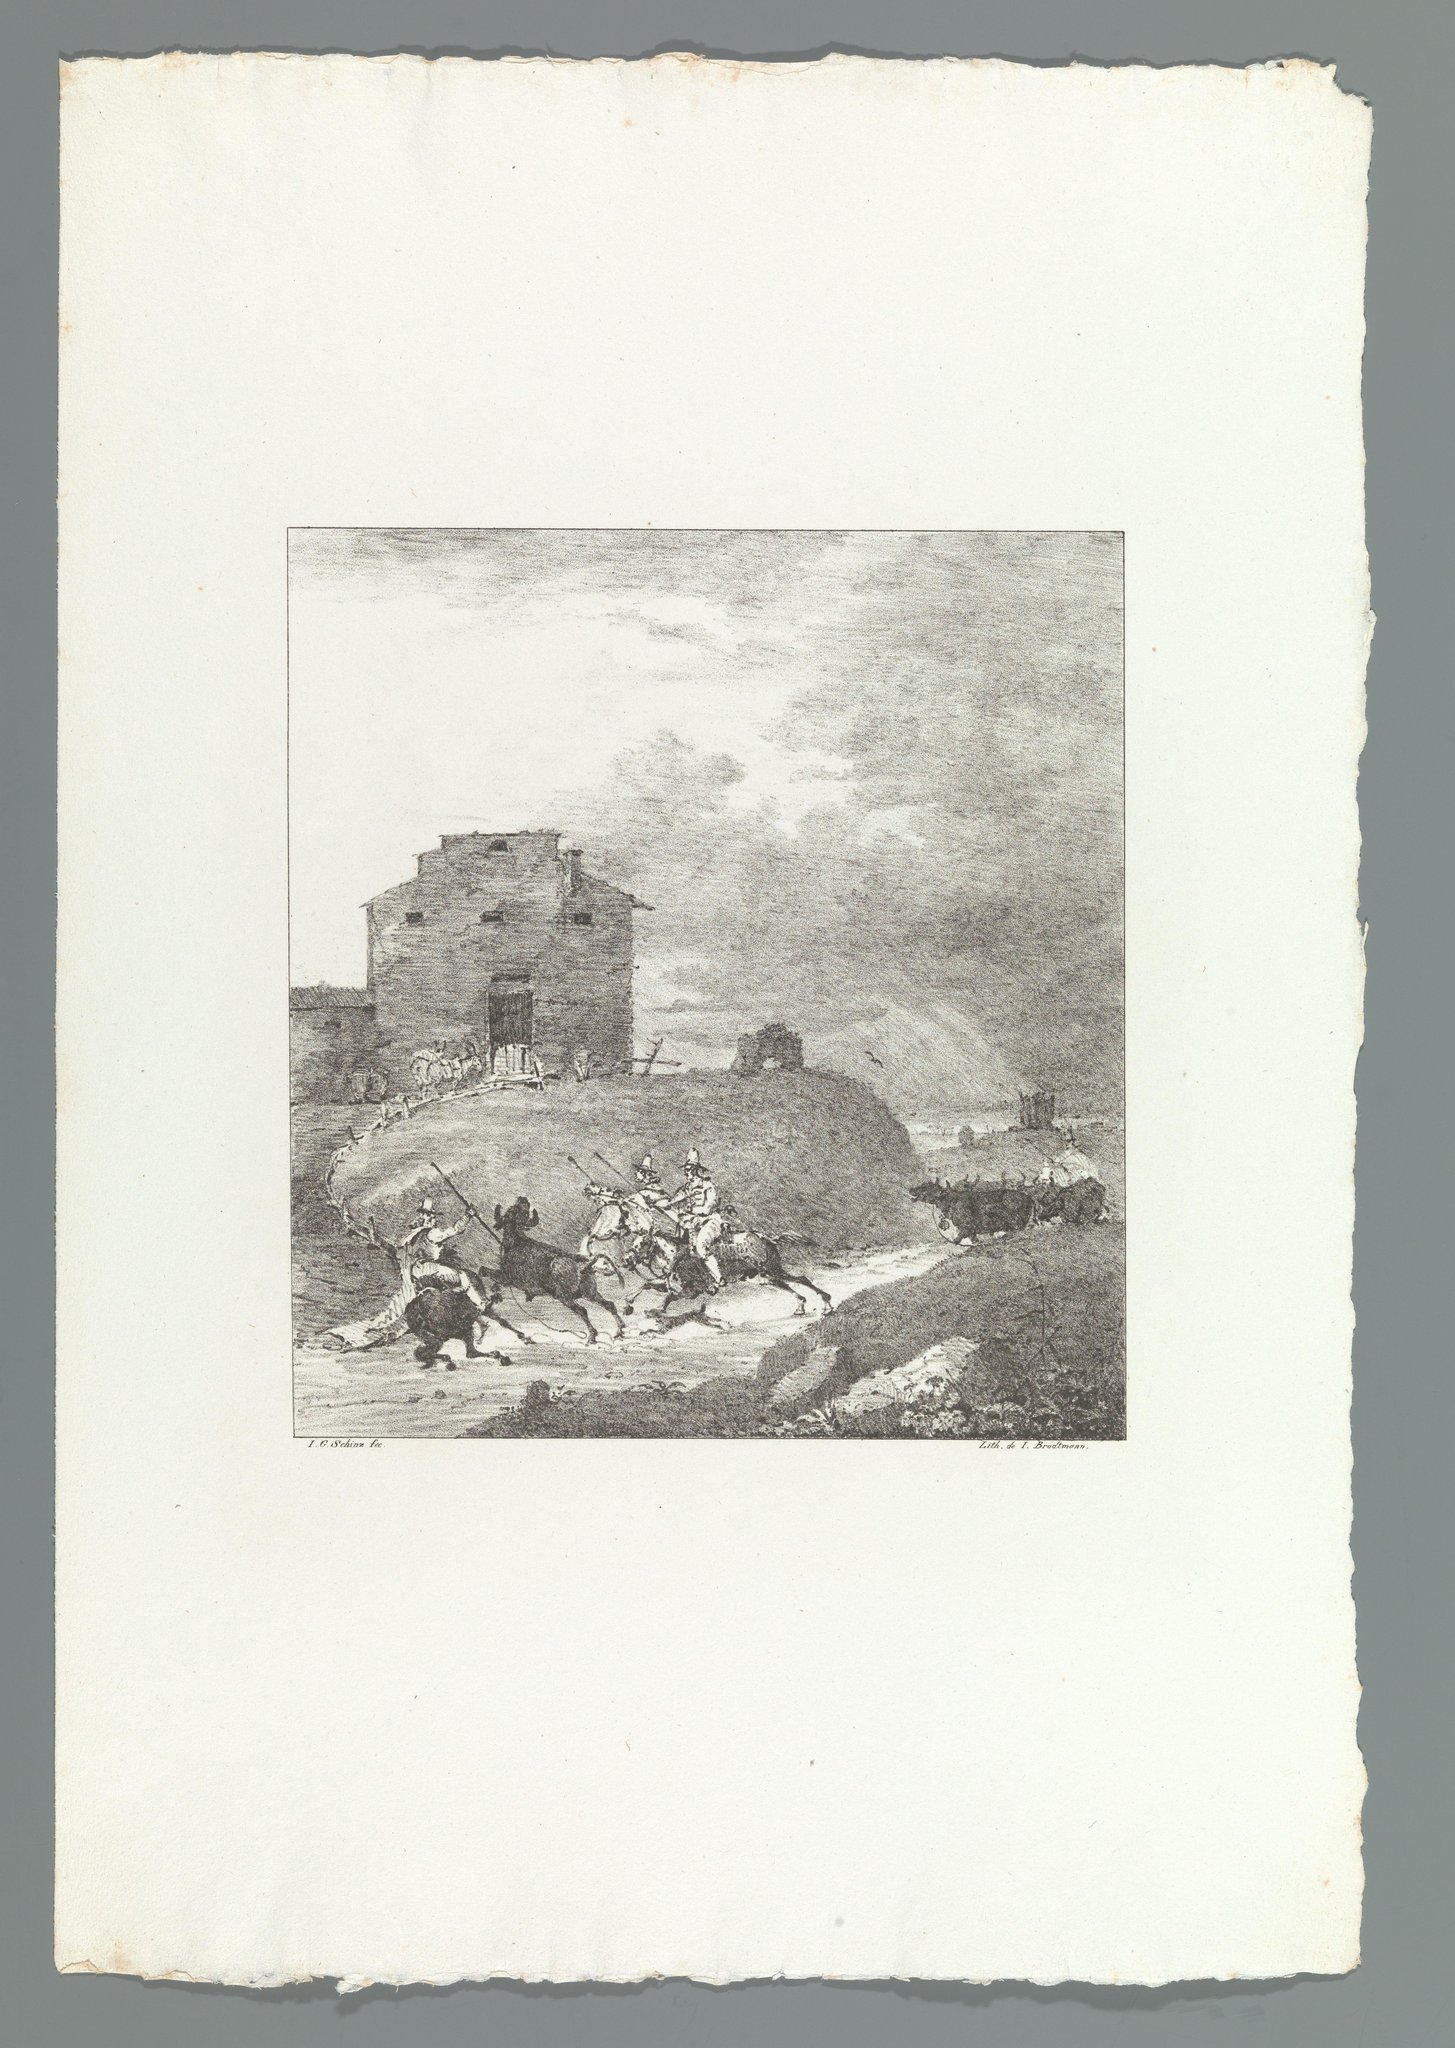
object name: print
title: Ruiters vangen een losgebroken jonge stier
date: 1822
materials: paper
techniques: lithograph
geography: zurich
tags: riding a horse, ass, or mule; rider, horseman, herding, herdsman, herdswoman, shepherd, shepherdess, cowherd, etc.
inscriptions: collector's mark: Lugt 2760, collector's mark: ‘RA WANKLER’, collector's mark: Lugt 2228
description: Krijtlitho afkomstig uit de 'Lithographische Original-Zeichnungen von J.G. Schinz, Zürich 1822'.